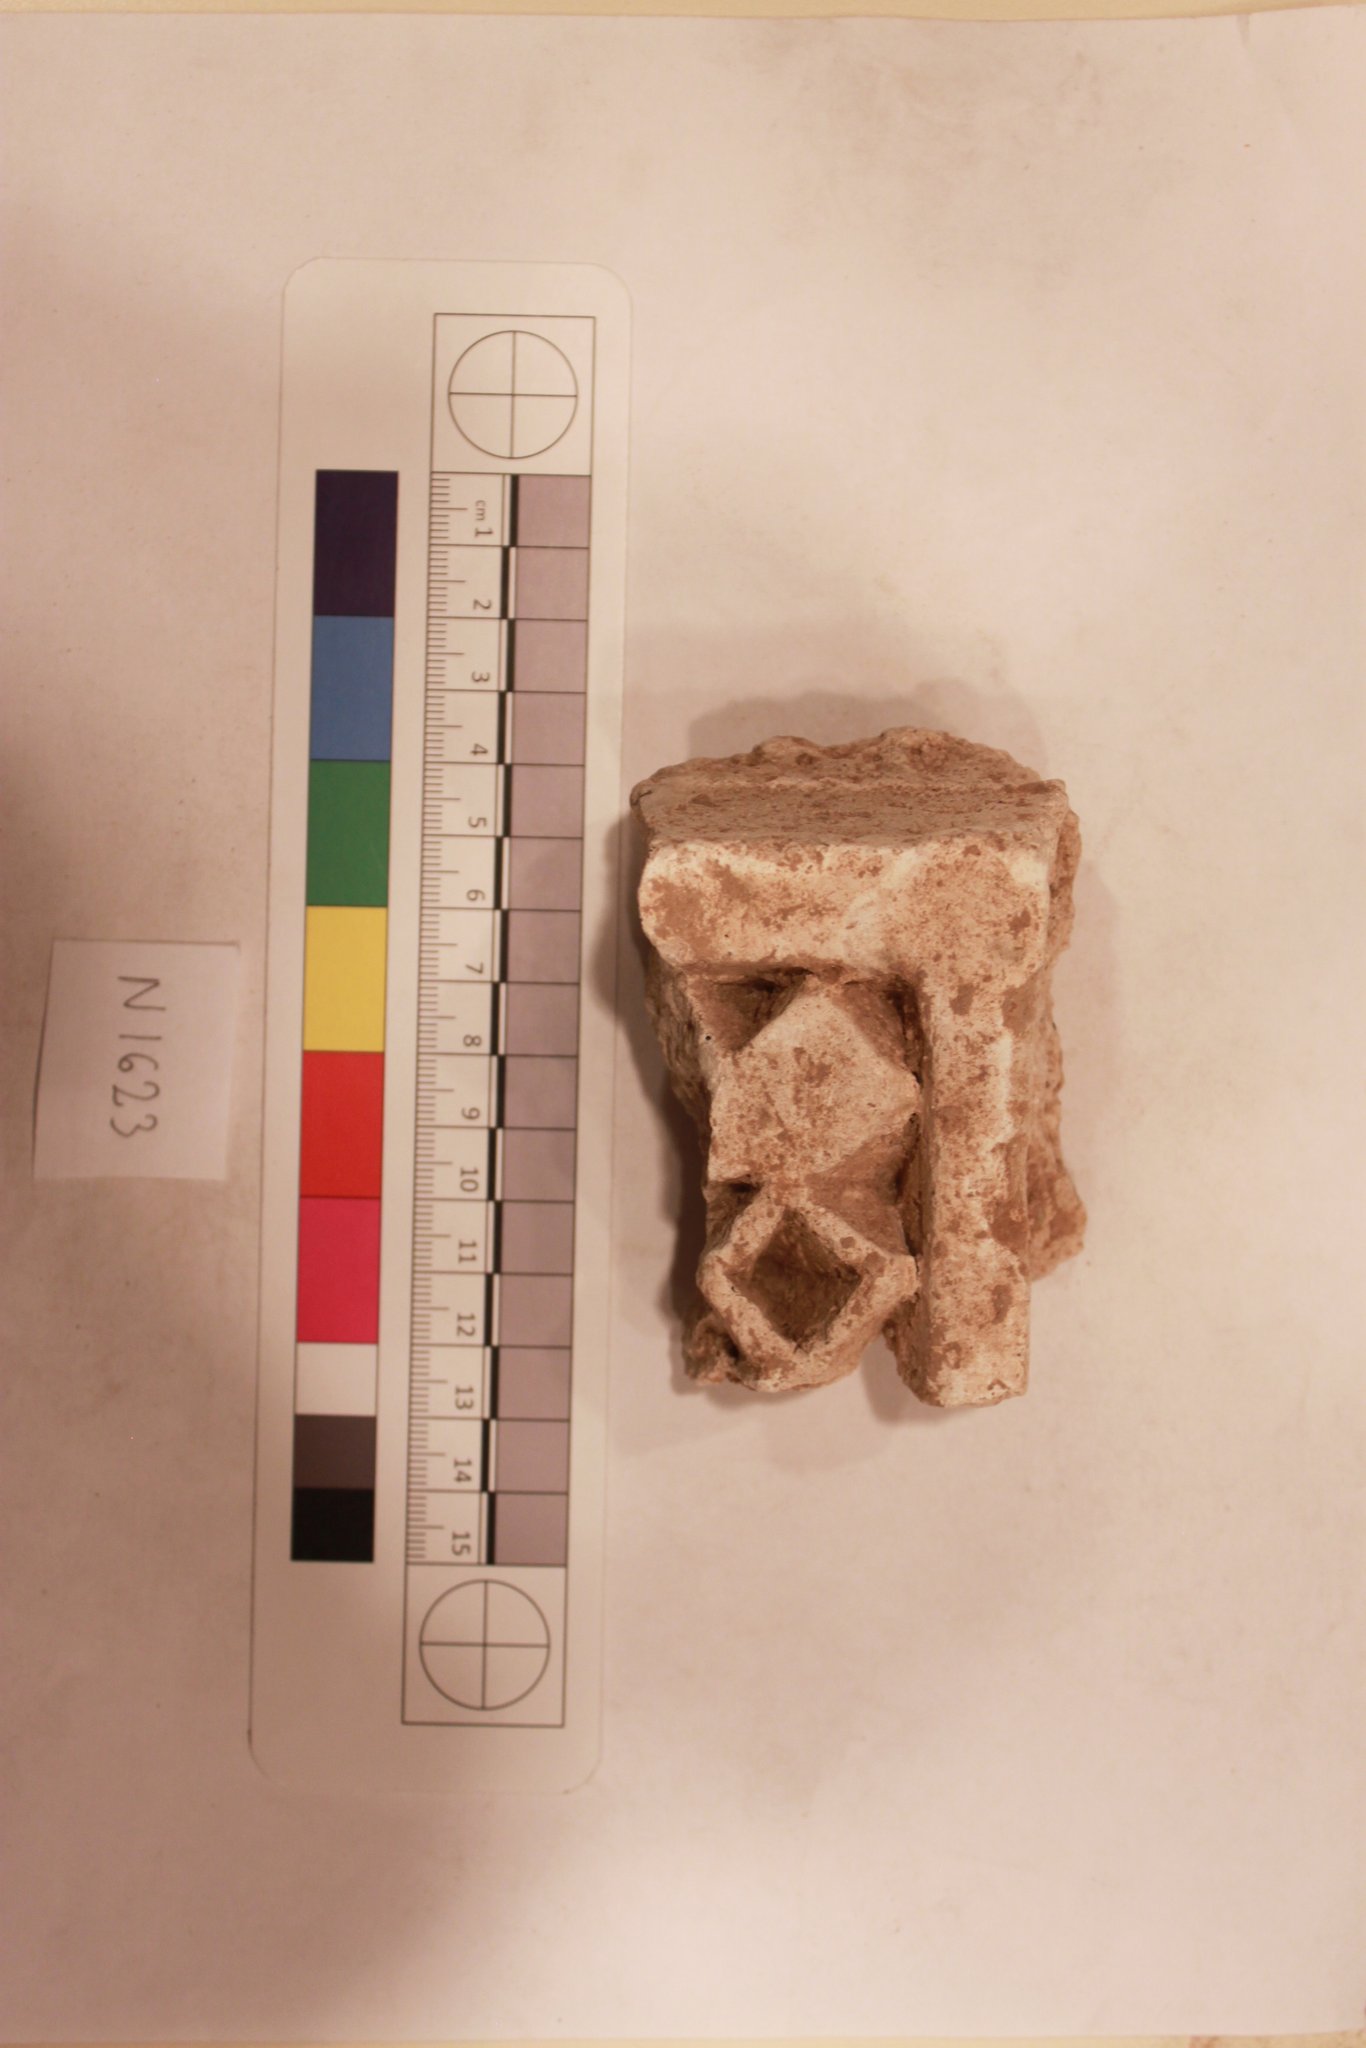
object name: fragment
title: Stucco Fragment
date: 701-1200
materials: plaster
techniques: carving, painting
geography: iran